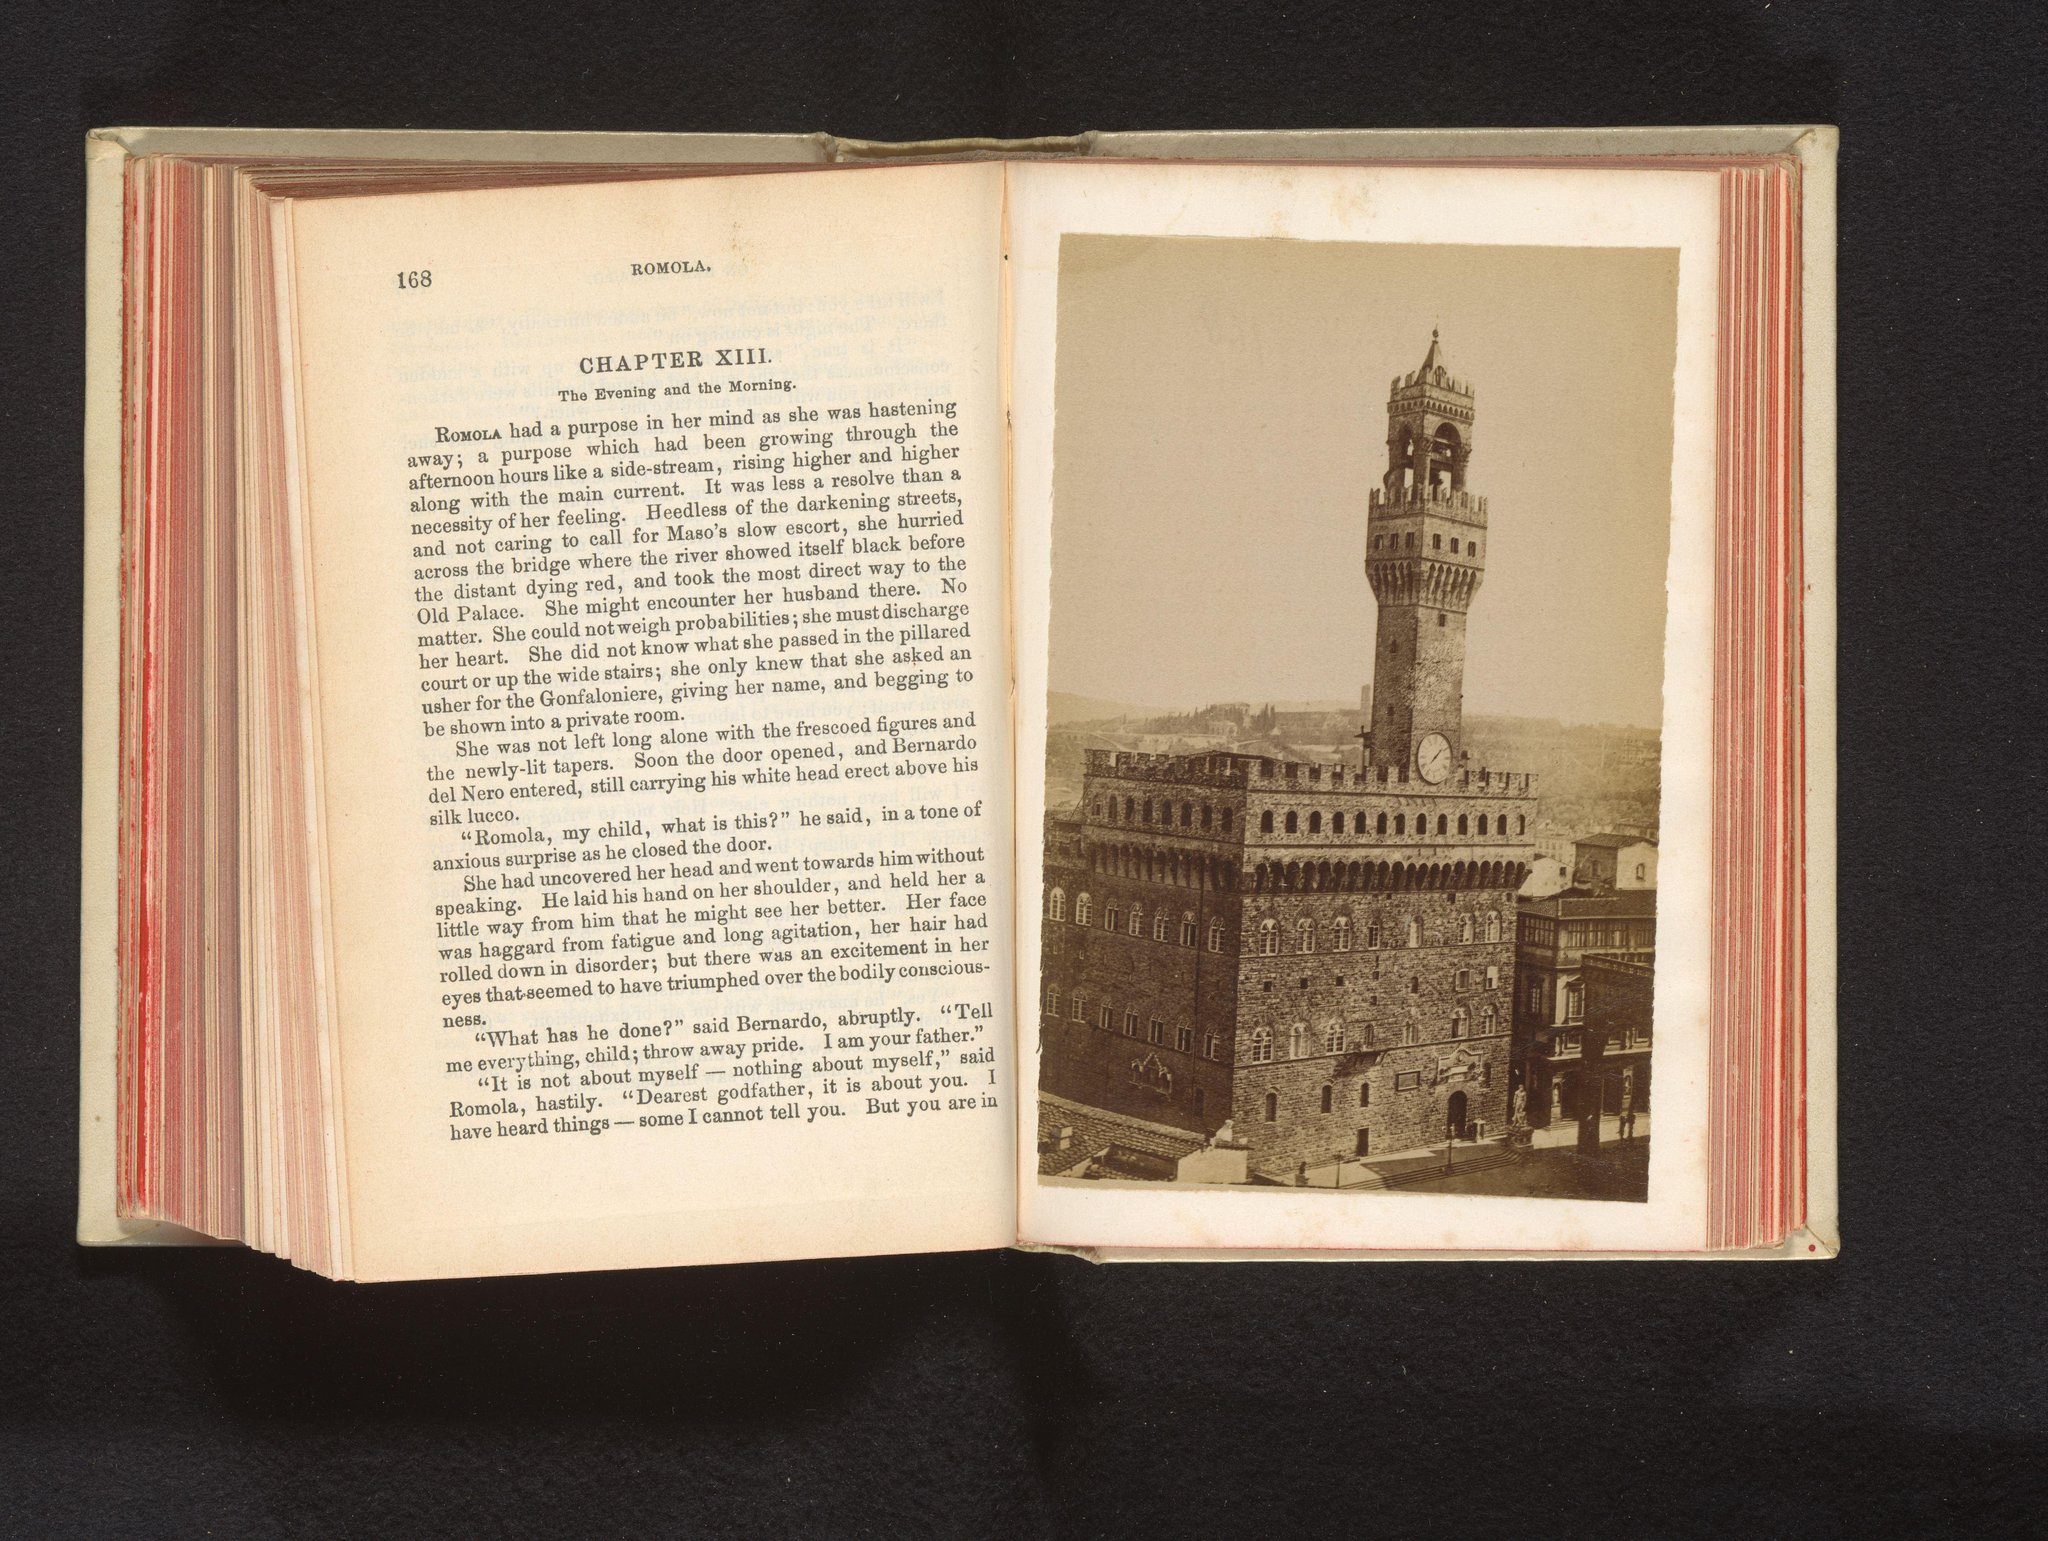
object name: photograph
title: Exterieur van het Palazzo Vecchio te Florence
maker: Anonymous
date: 1858-1863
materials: photographic support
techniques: albumen print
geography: florence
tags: hôtel, i.e. small palace in city, façade (of house or building)